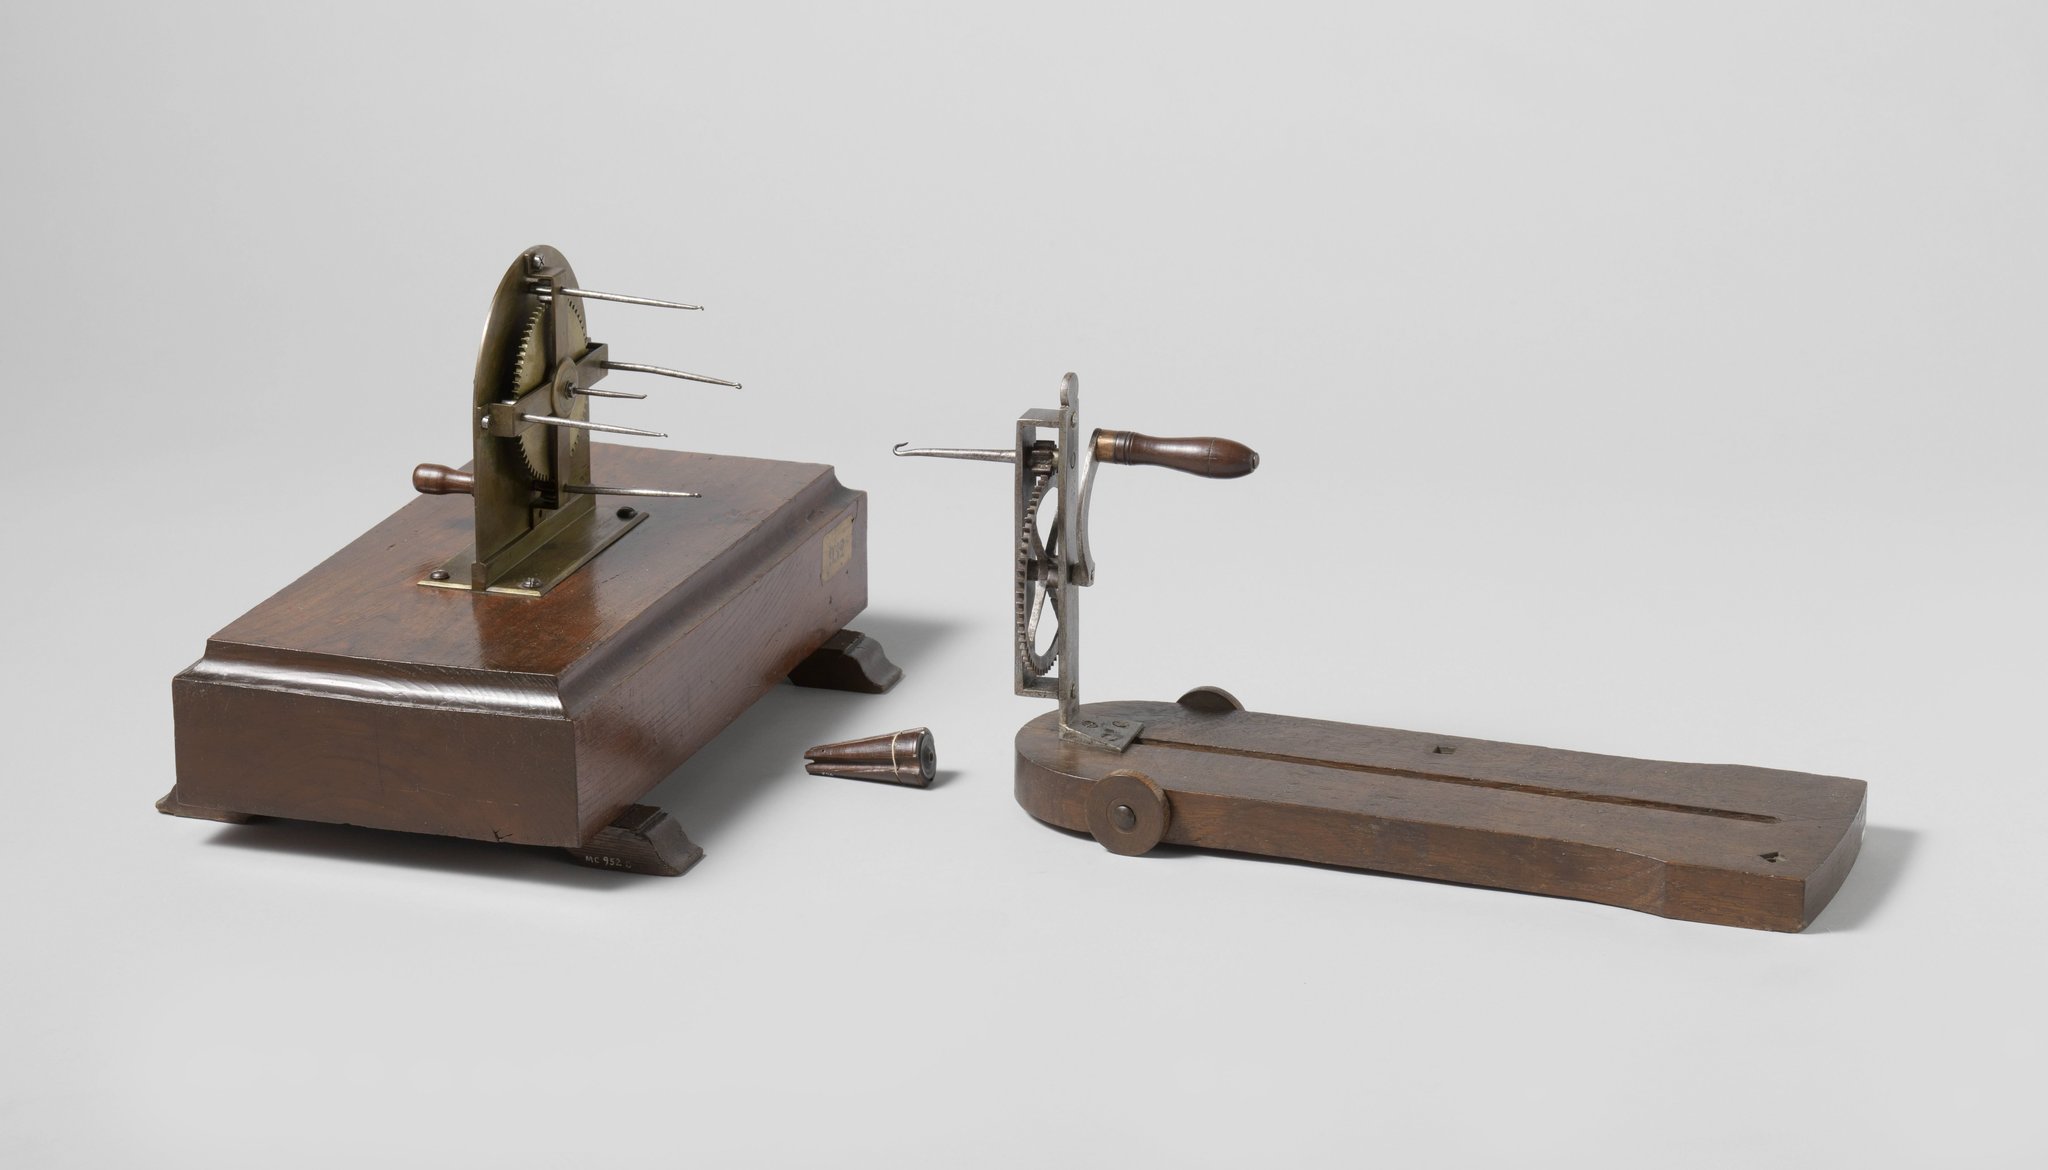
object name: tool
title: Tackle Board, Sledge and Top for Rope Making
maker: Anonymous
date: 1800-1860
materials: brass, iron, wood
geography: netherlands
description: A ropeyard or ropery comprises a spinning wheel for pre-twisting strands of string, a sledge for twisting five strands together, and a top to prevent the strands from tangling during twisting. This miniature ropeyard was once the equipment used by a modelmaker.